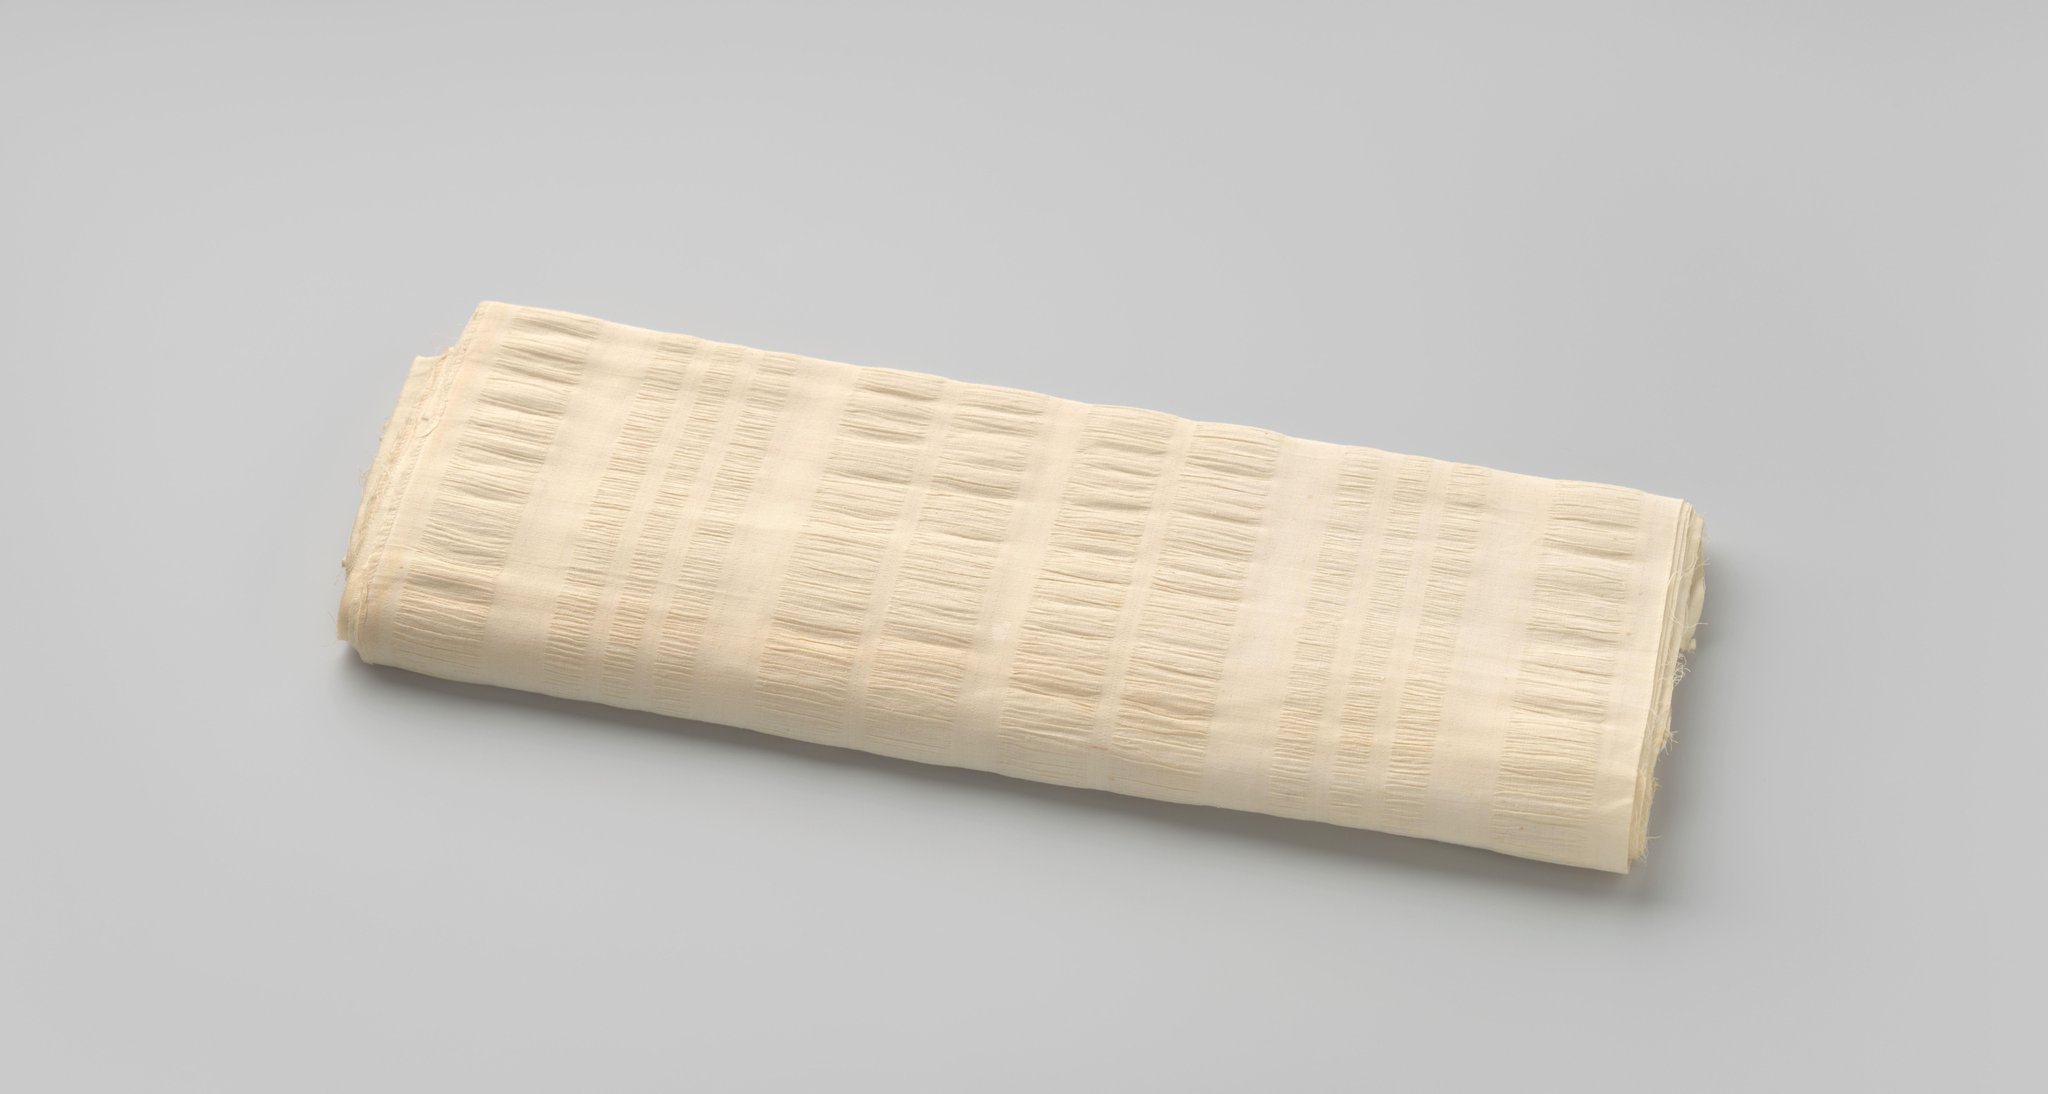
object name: coupon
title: Coupon witte katoen met crêpe en gladde weefbanen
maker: gustav schnitzler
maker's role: paraplufabrikant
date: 1910-1940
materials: cotton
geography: nijmegen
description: Metrage parasolkatoen, stukgoed. In effen wit en met crêpe en gladde weefbanen.